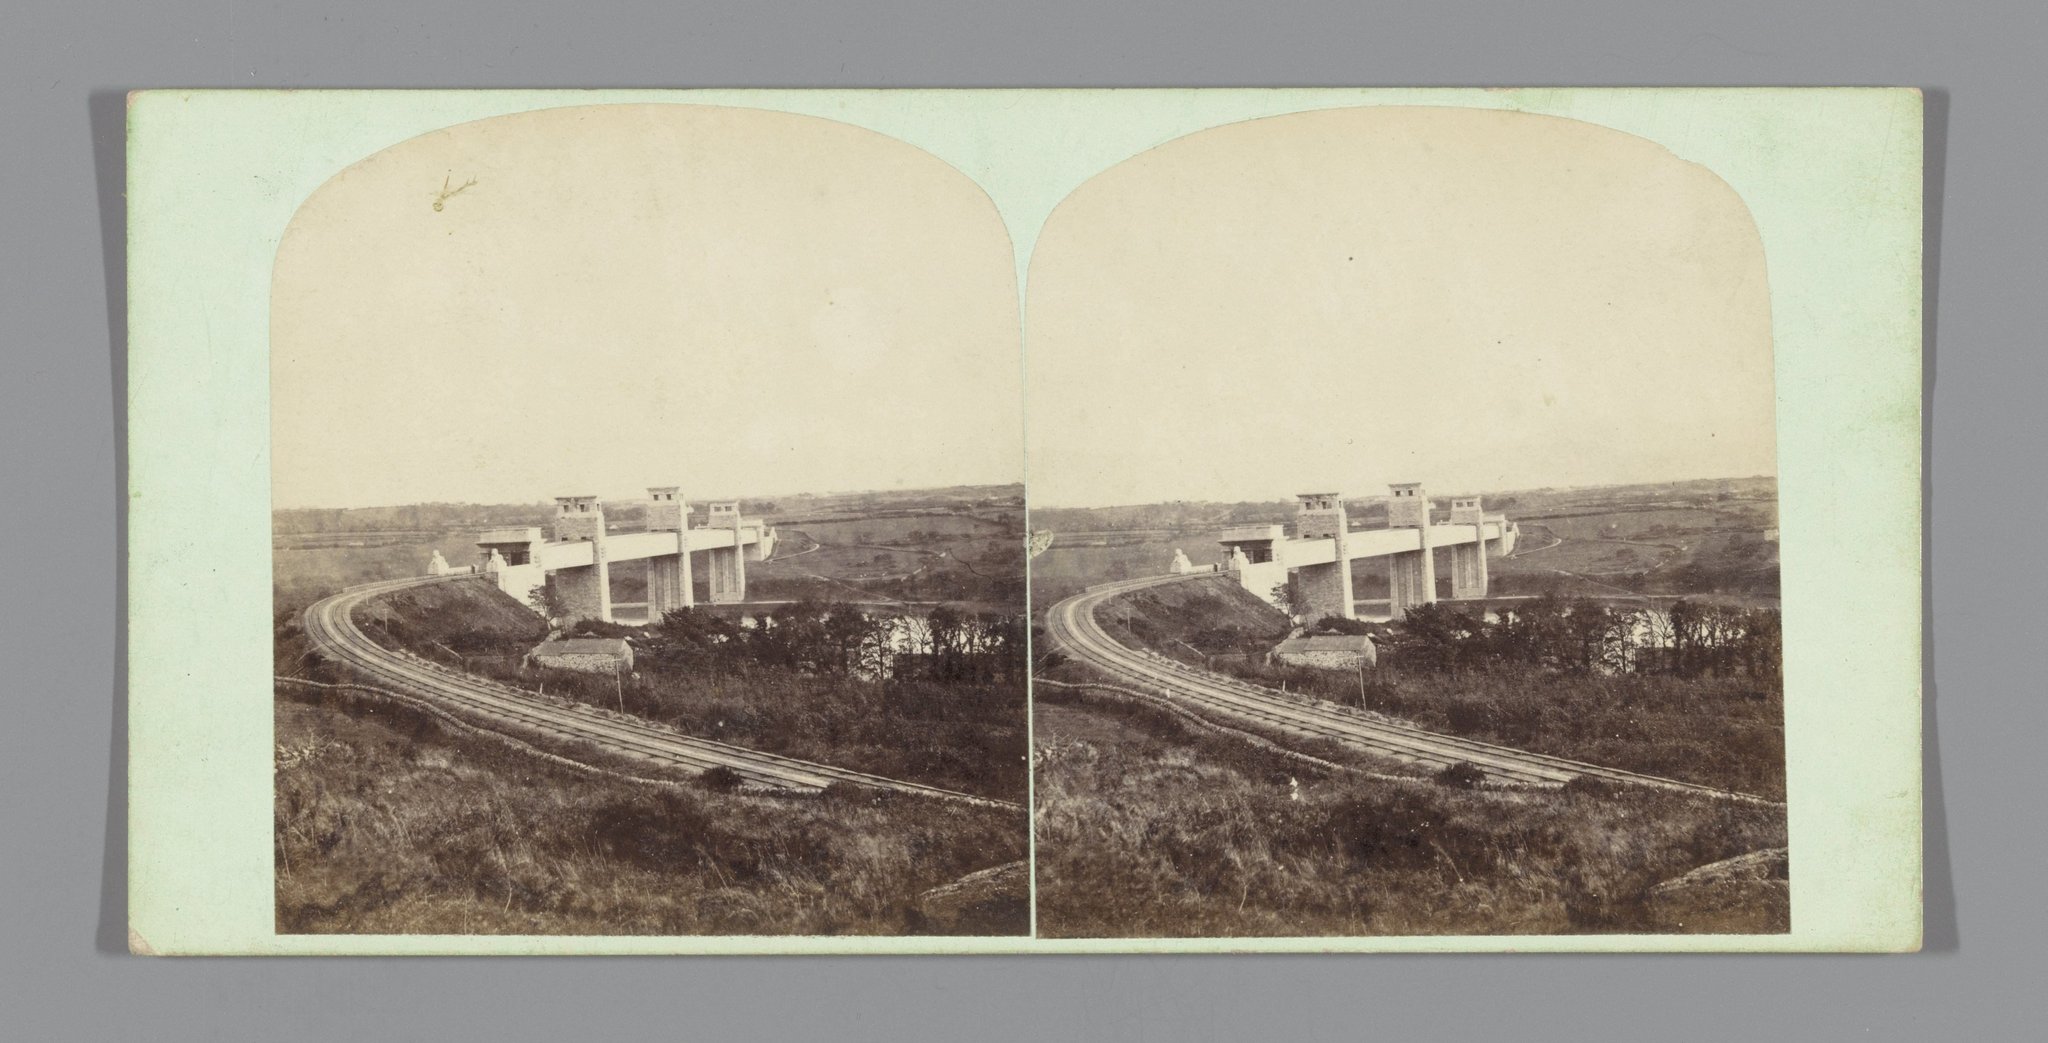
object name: stereograph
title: Gezicht op de Britannia Bridge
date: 1850-1880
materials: cardboard, photographic support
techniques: albumen print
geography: manchester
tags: bridge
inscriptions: name: ‘Photographed and published by The Manchester Photographic Company, Limited, 84, Market Street, Manchester.’, inscription: ‘North Wales.’, number: ‘No. 569.’